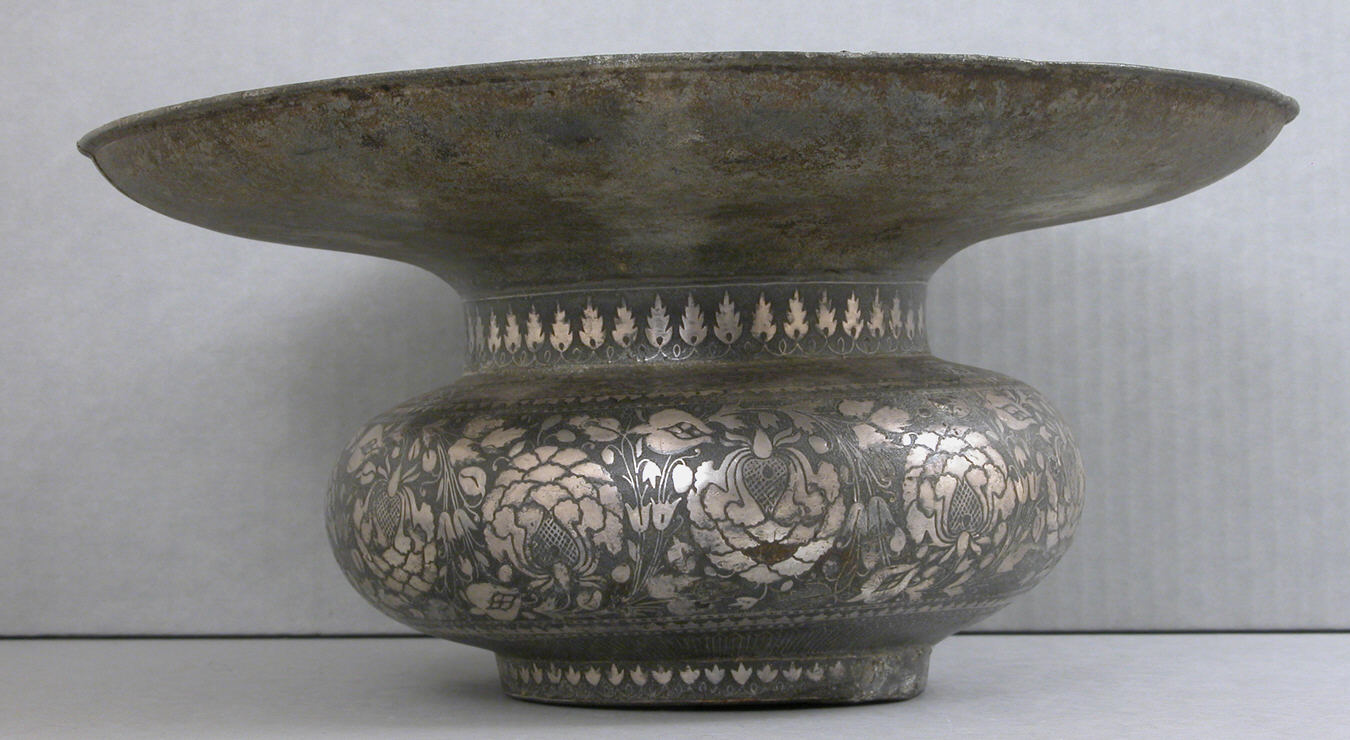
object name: basin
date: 1701-1900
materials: alloy, silver, zinc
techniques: casting, engraving, inlay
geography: india